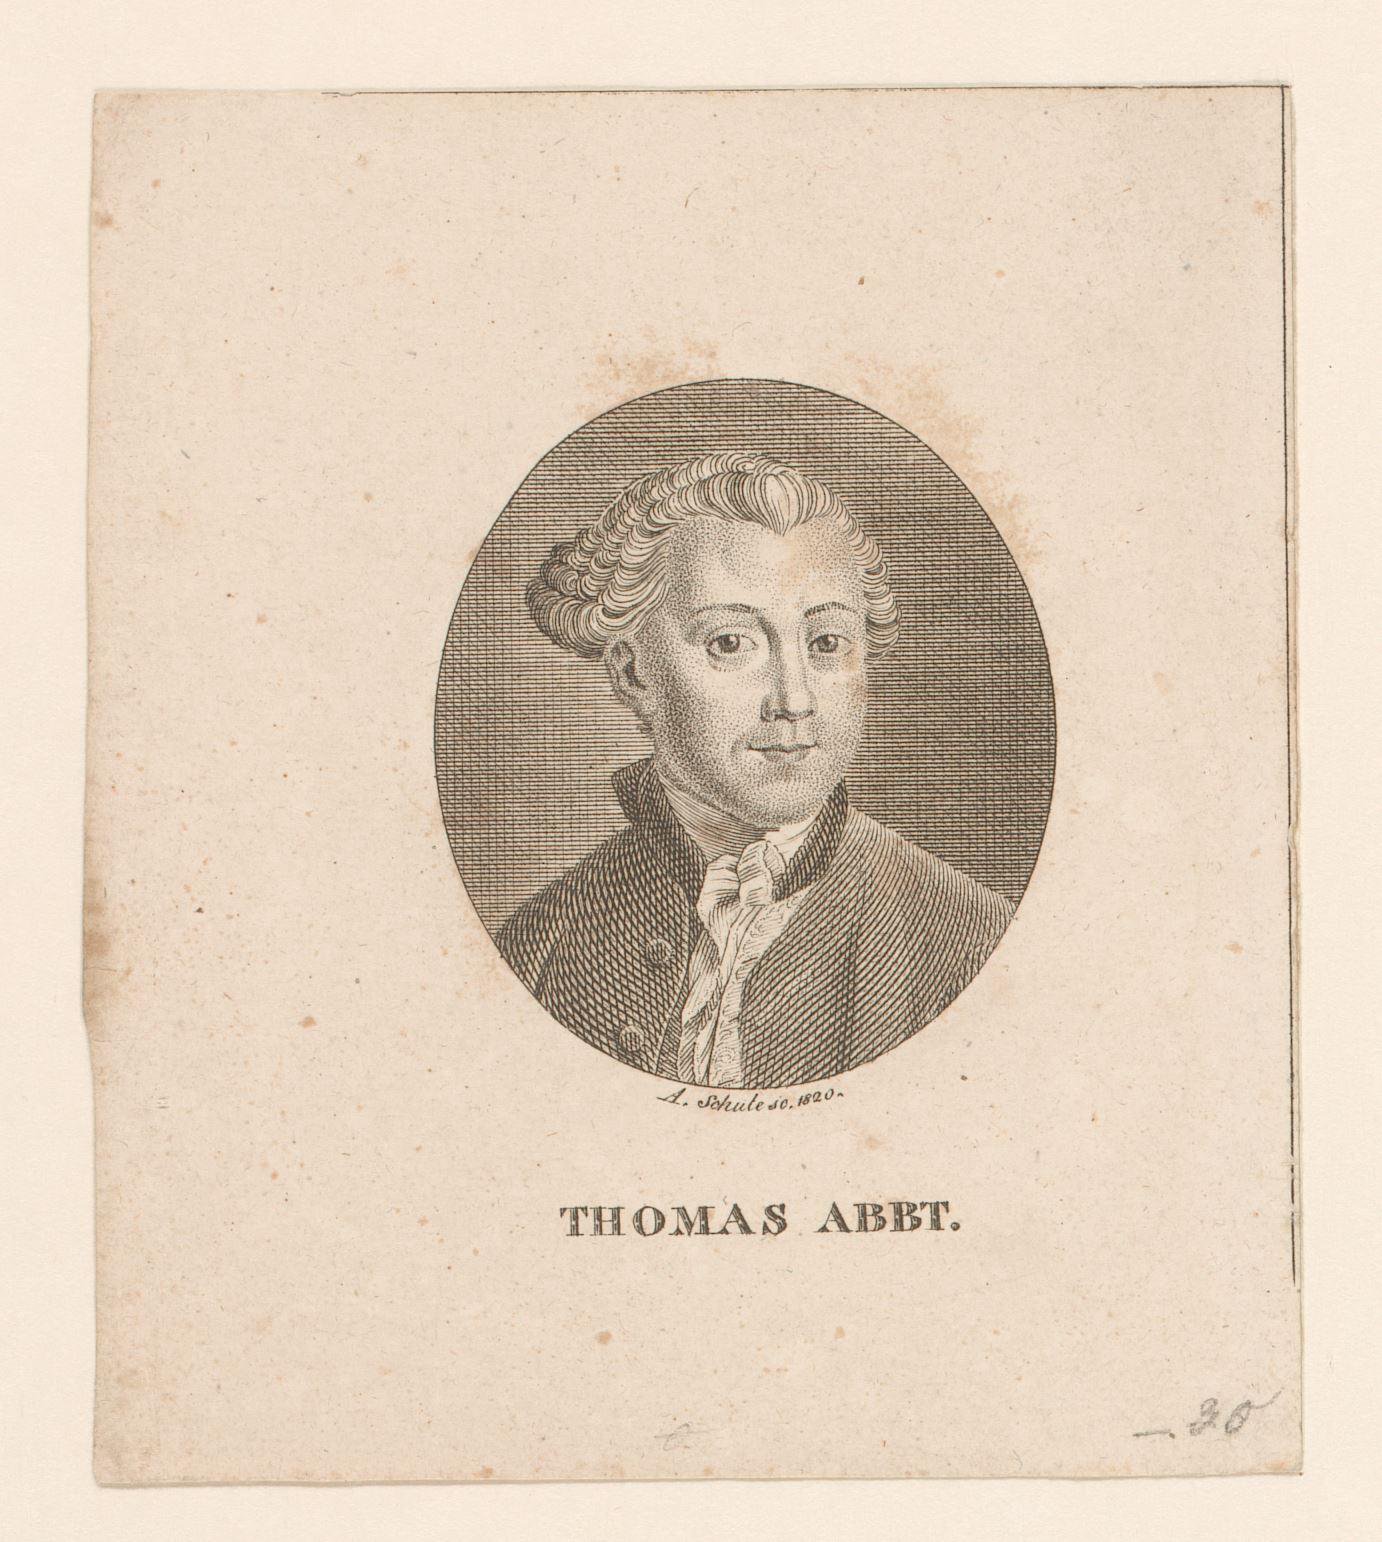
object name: print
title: Portret van Thomas Abbt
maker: albert schule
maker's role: painter, print maker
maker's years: 1801-1875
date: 1820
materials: paper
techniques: engraving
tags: historical persons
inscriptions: collector's mark: Lugt 2228